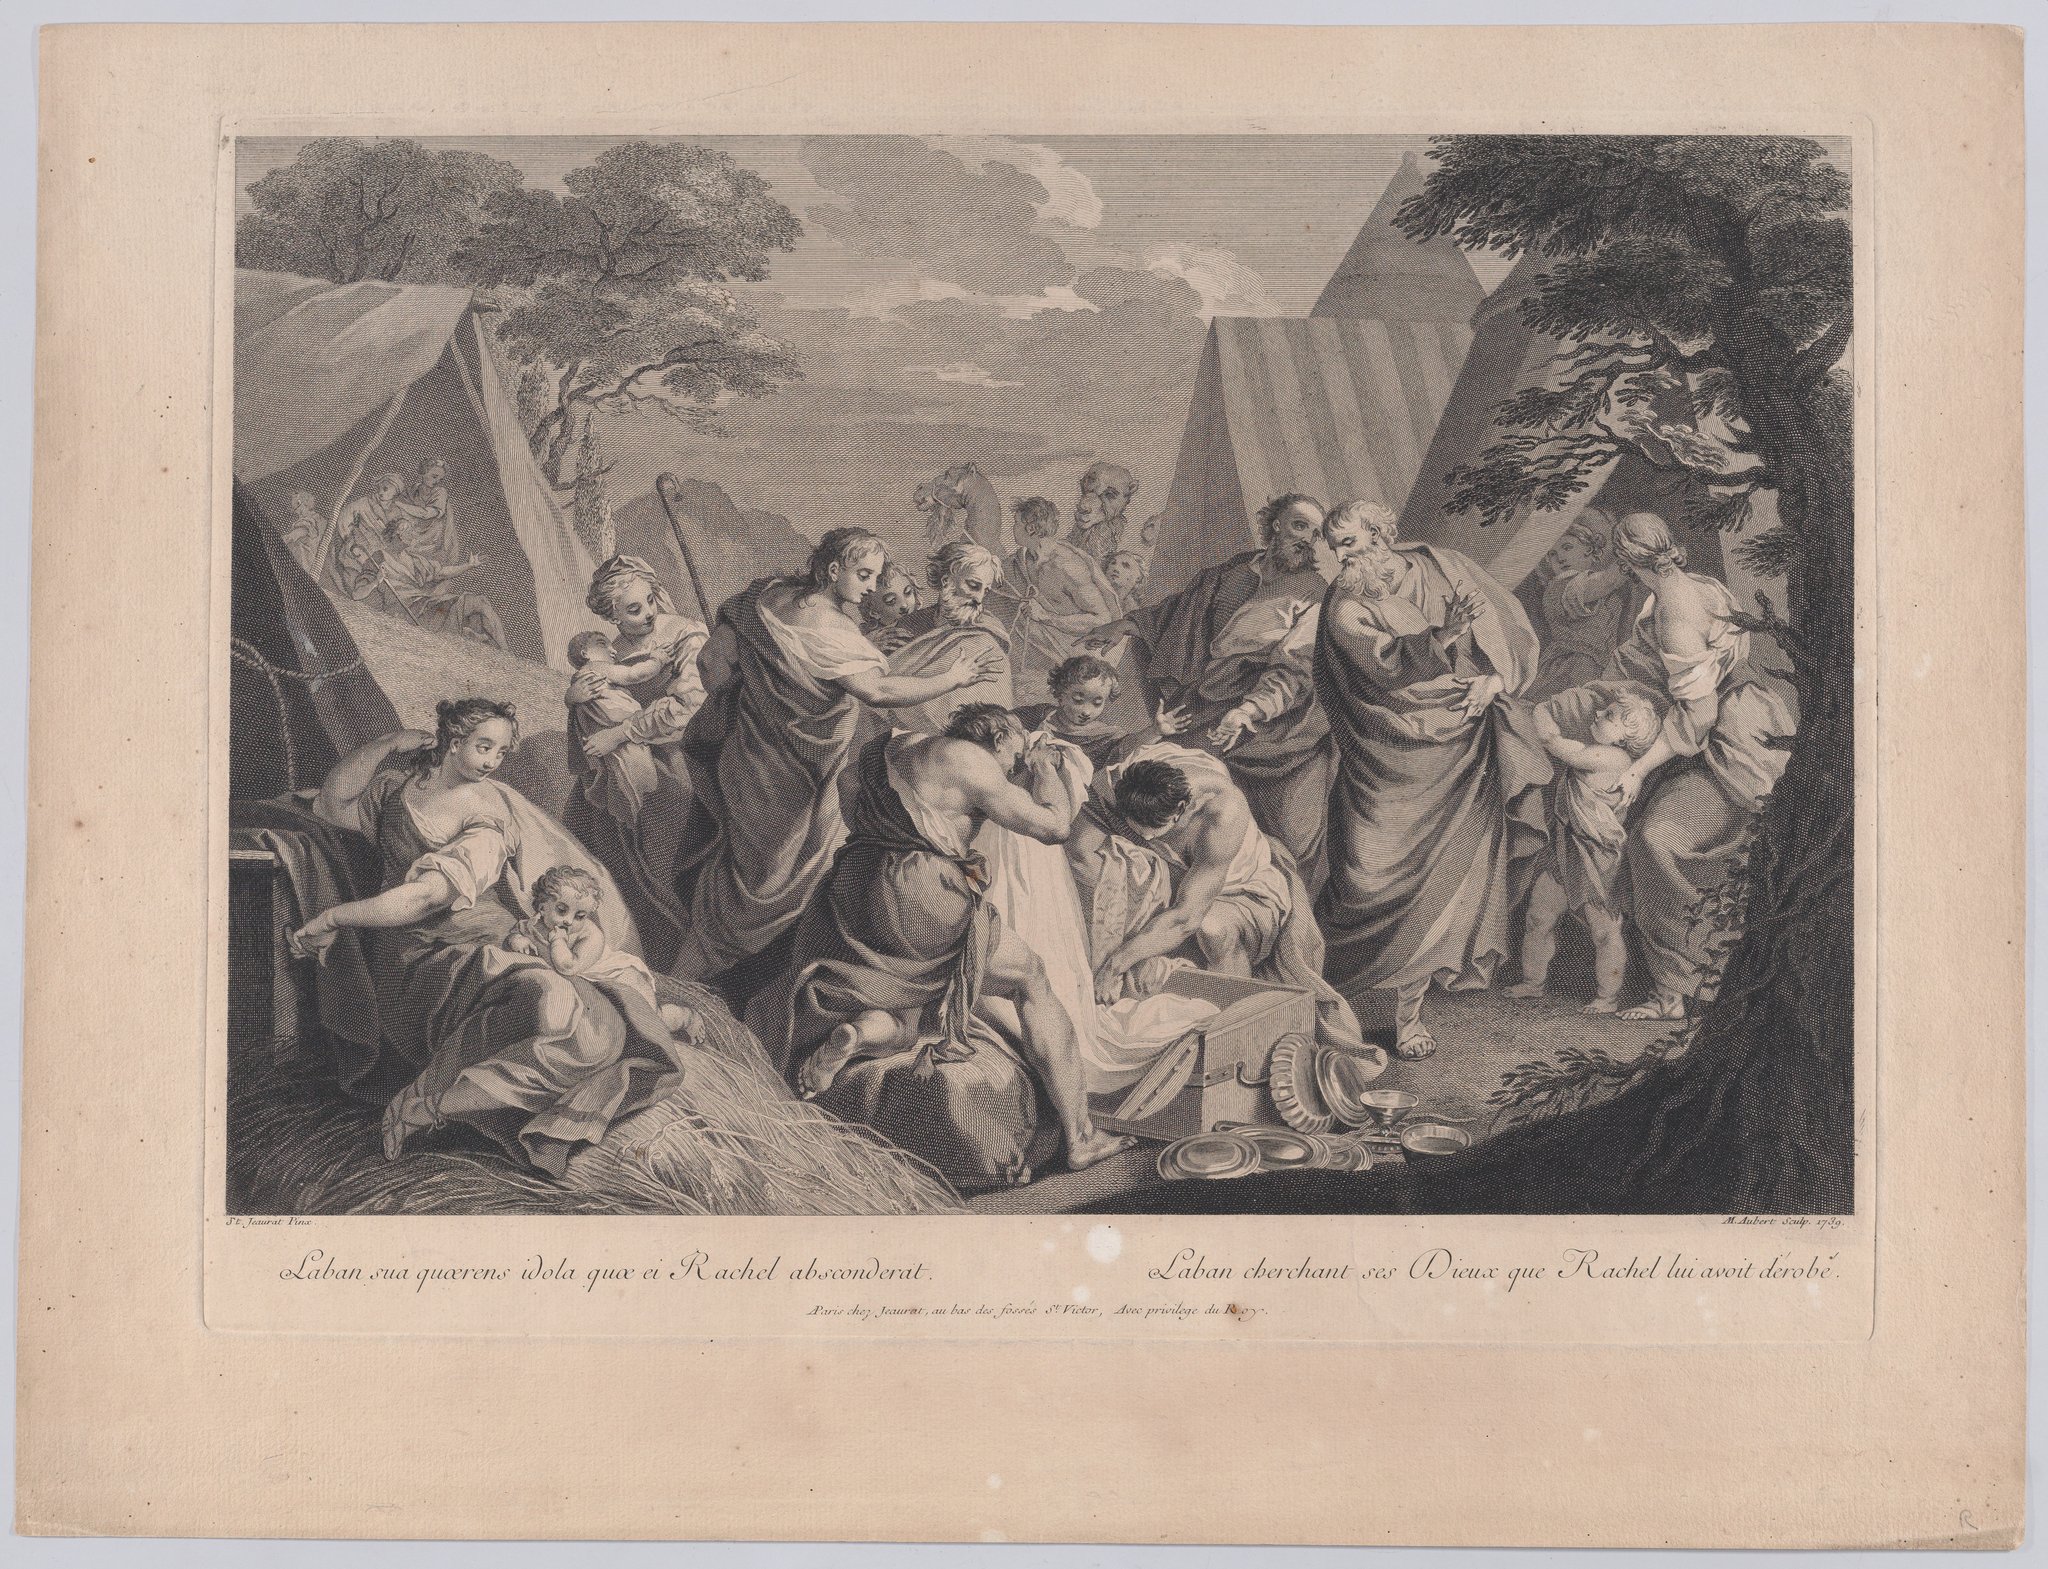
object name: print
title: Laban Searching for his Gods, after Etienne Jeaurat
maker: michel aubert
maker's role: artist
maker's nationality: french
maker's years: 1700-1757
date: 1739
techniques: etching